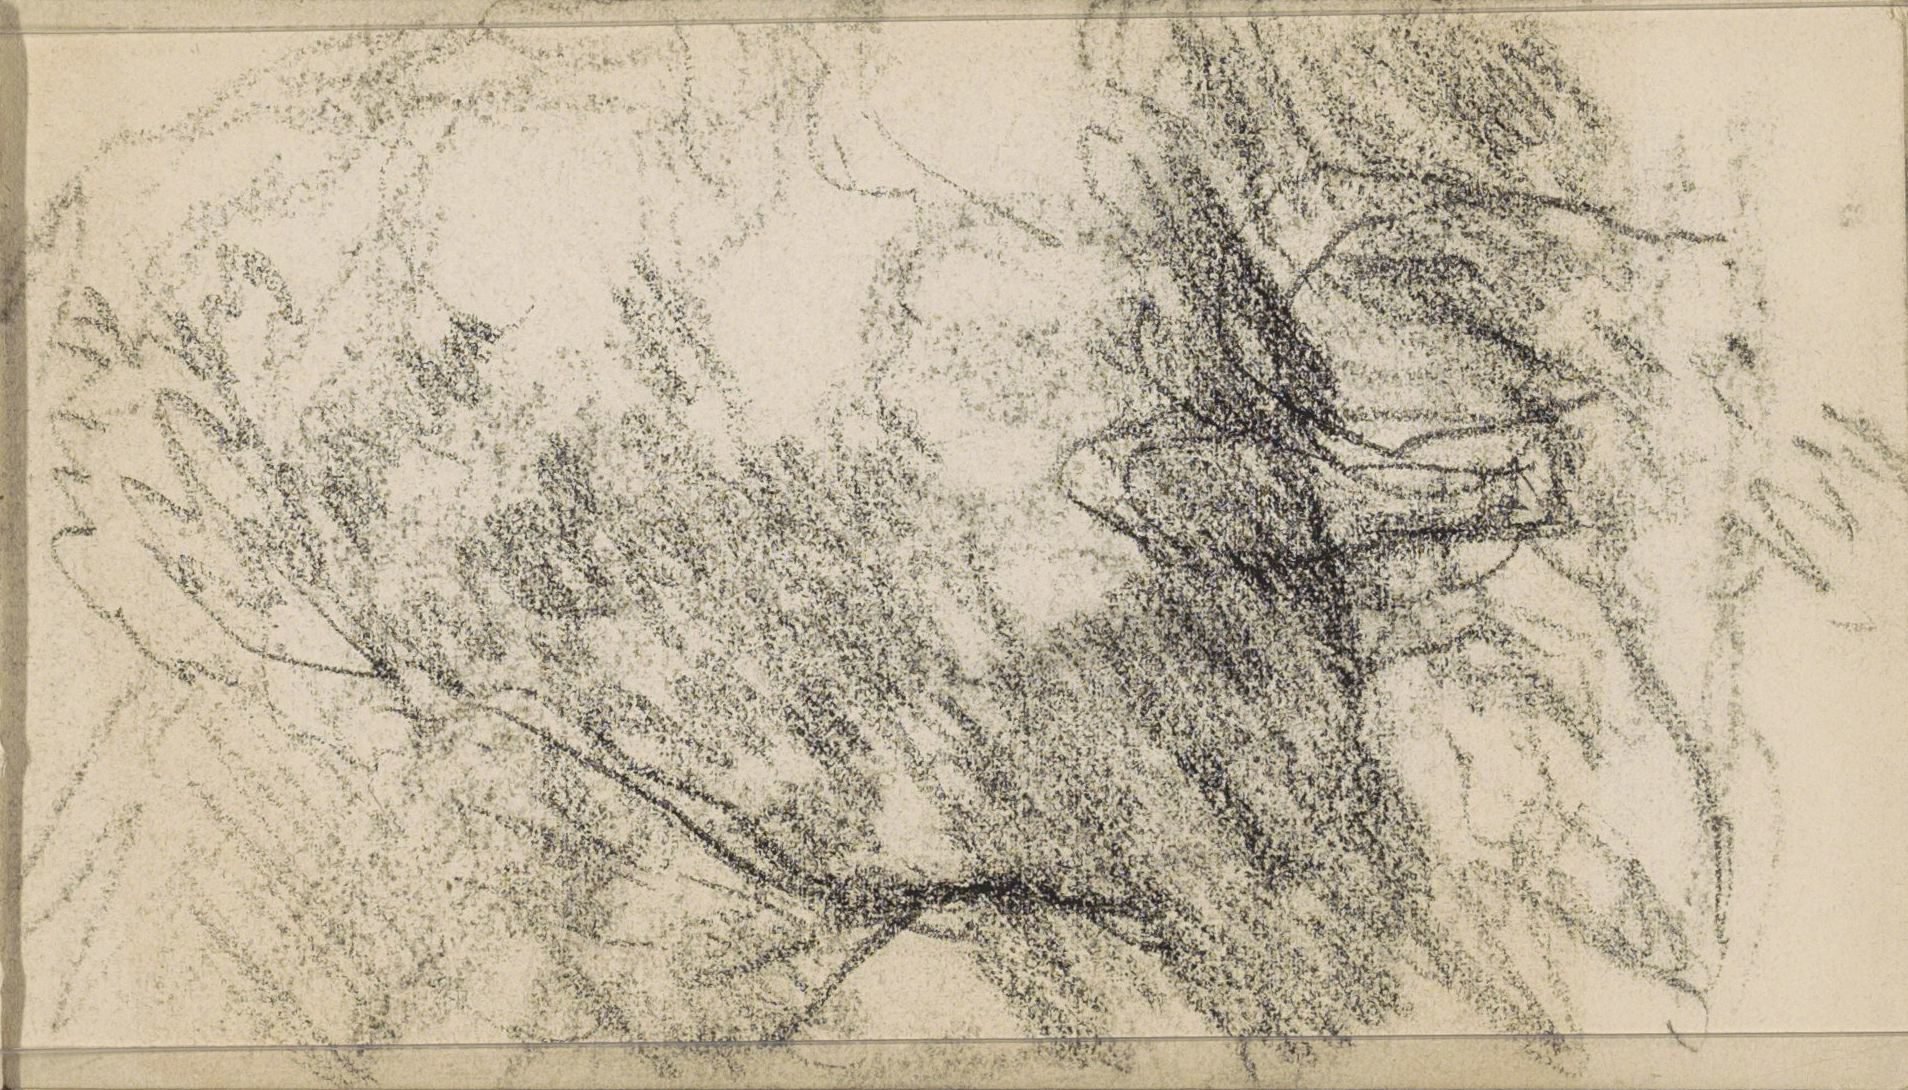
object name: sketchbook leaf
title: Landschap met bomen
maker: anton mauve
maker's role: draughtsman, painter, print maker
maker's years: 1838-1888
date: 1876-1879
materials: chalk, paper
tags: landscapes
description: Blad 19 recto uit een schetsboek met 33 bladen.